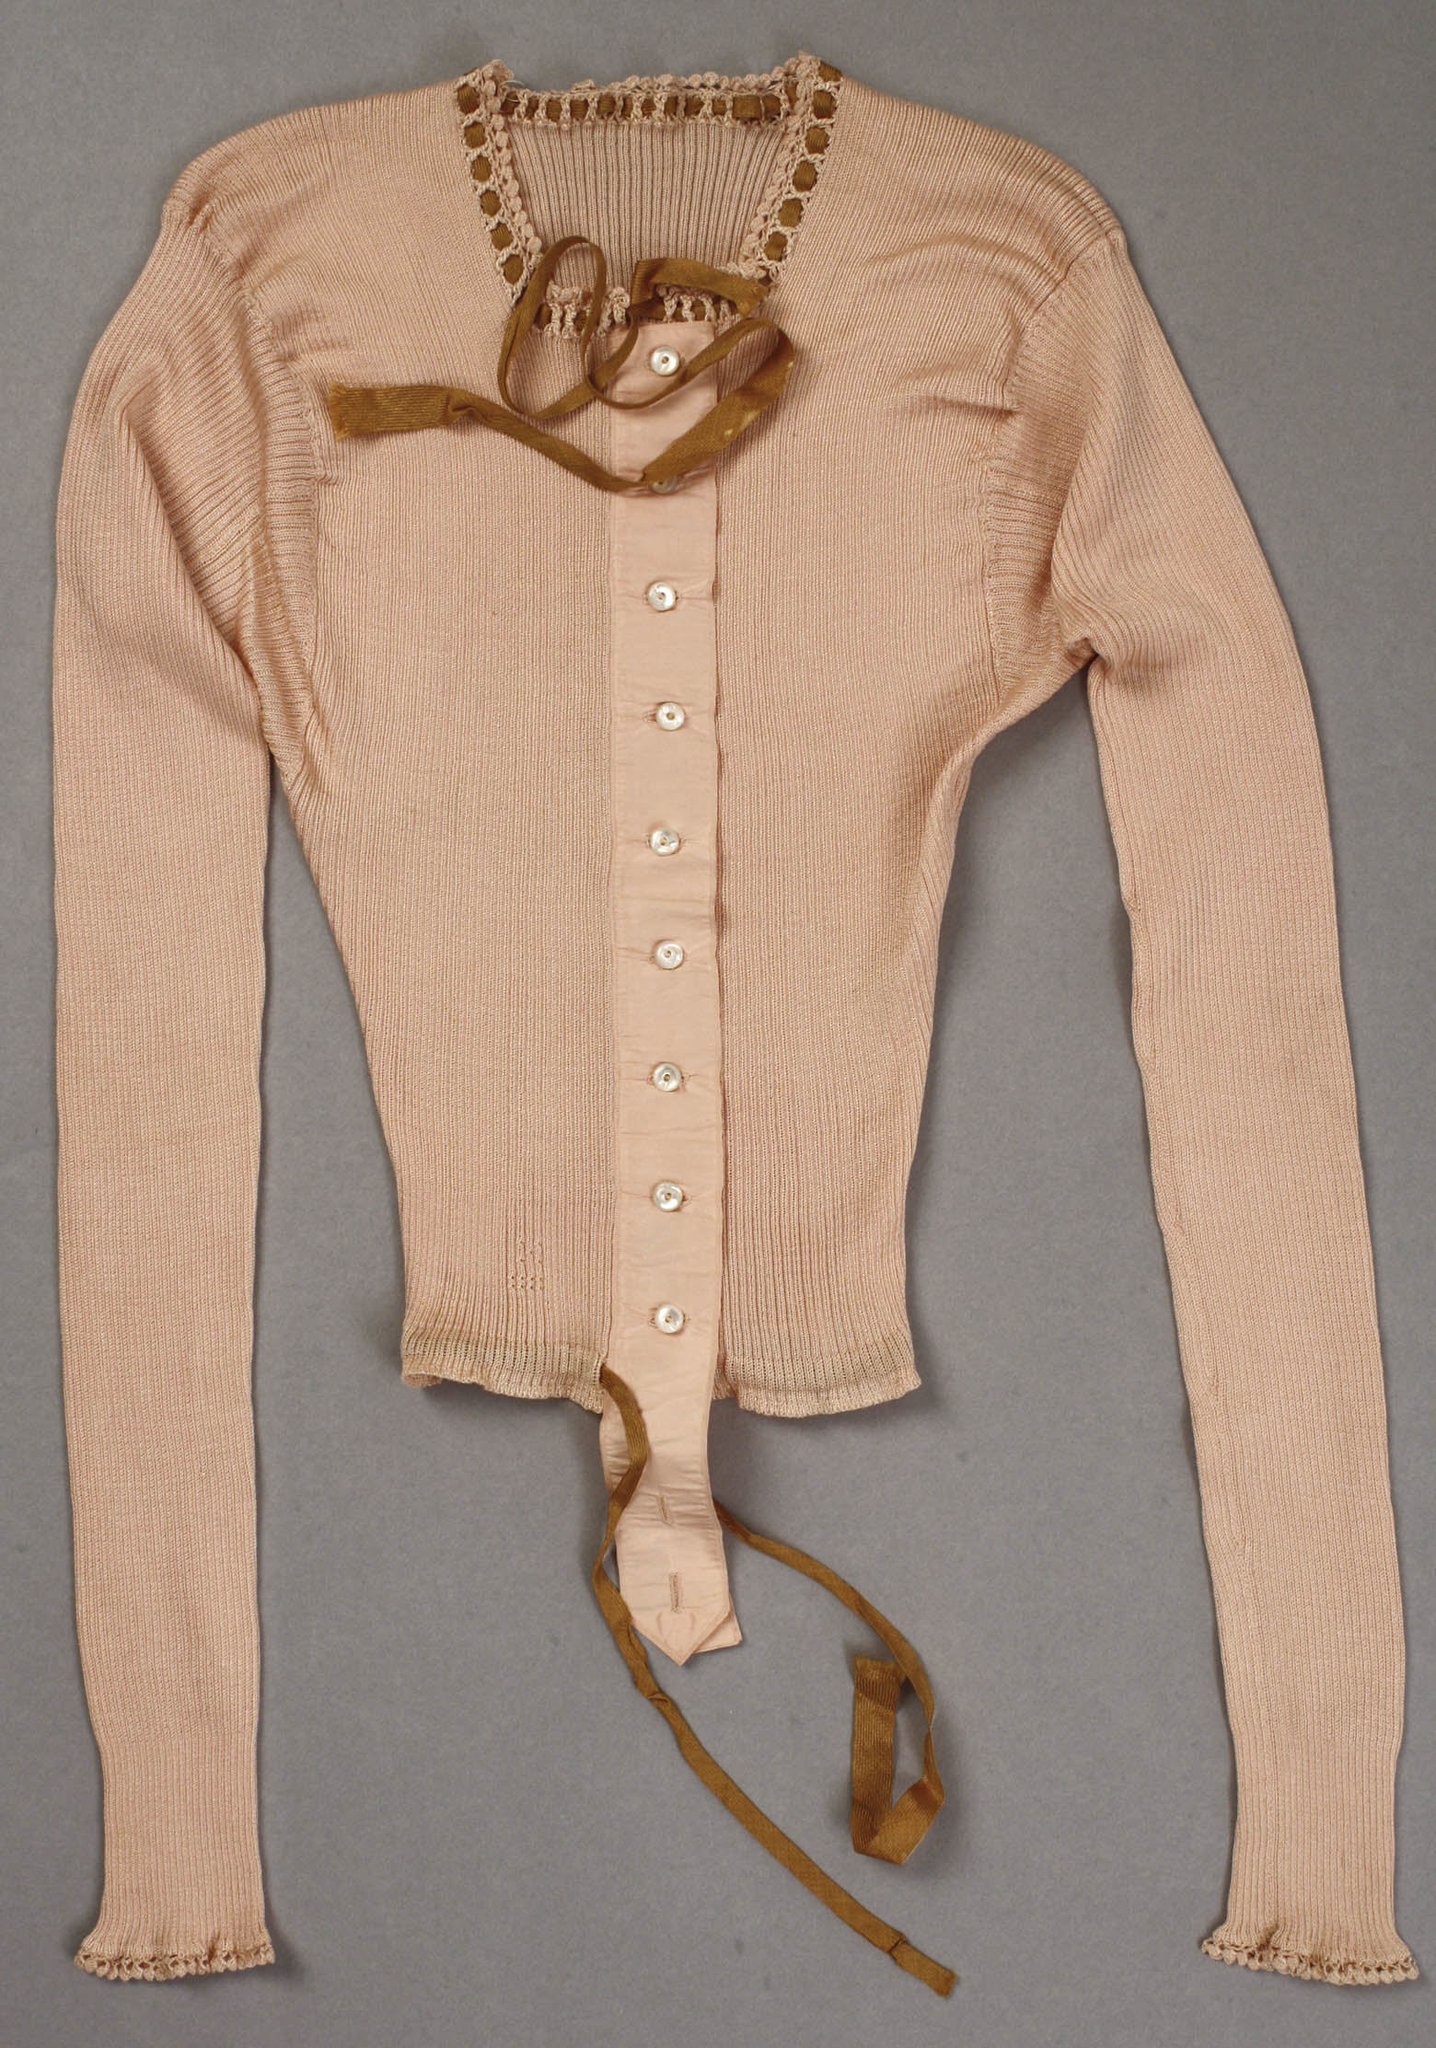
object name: undershirt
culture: french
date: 1885-1895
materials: cotton, silk